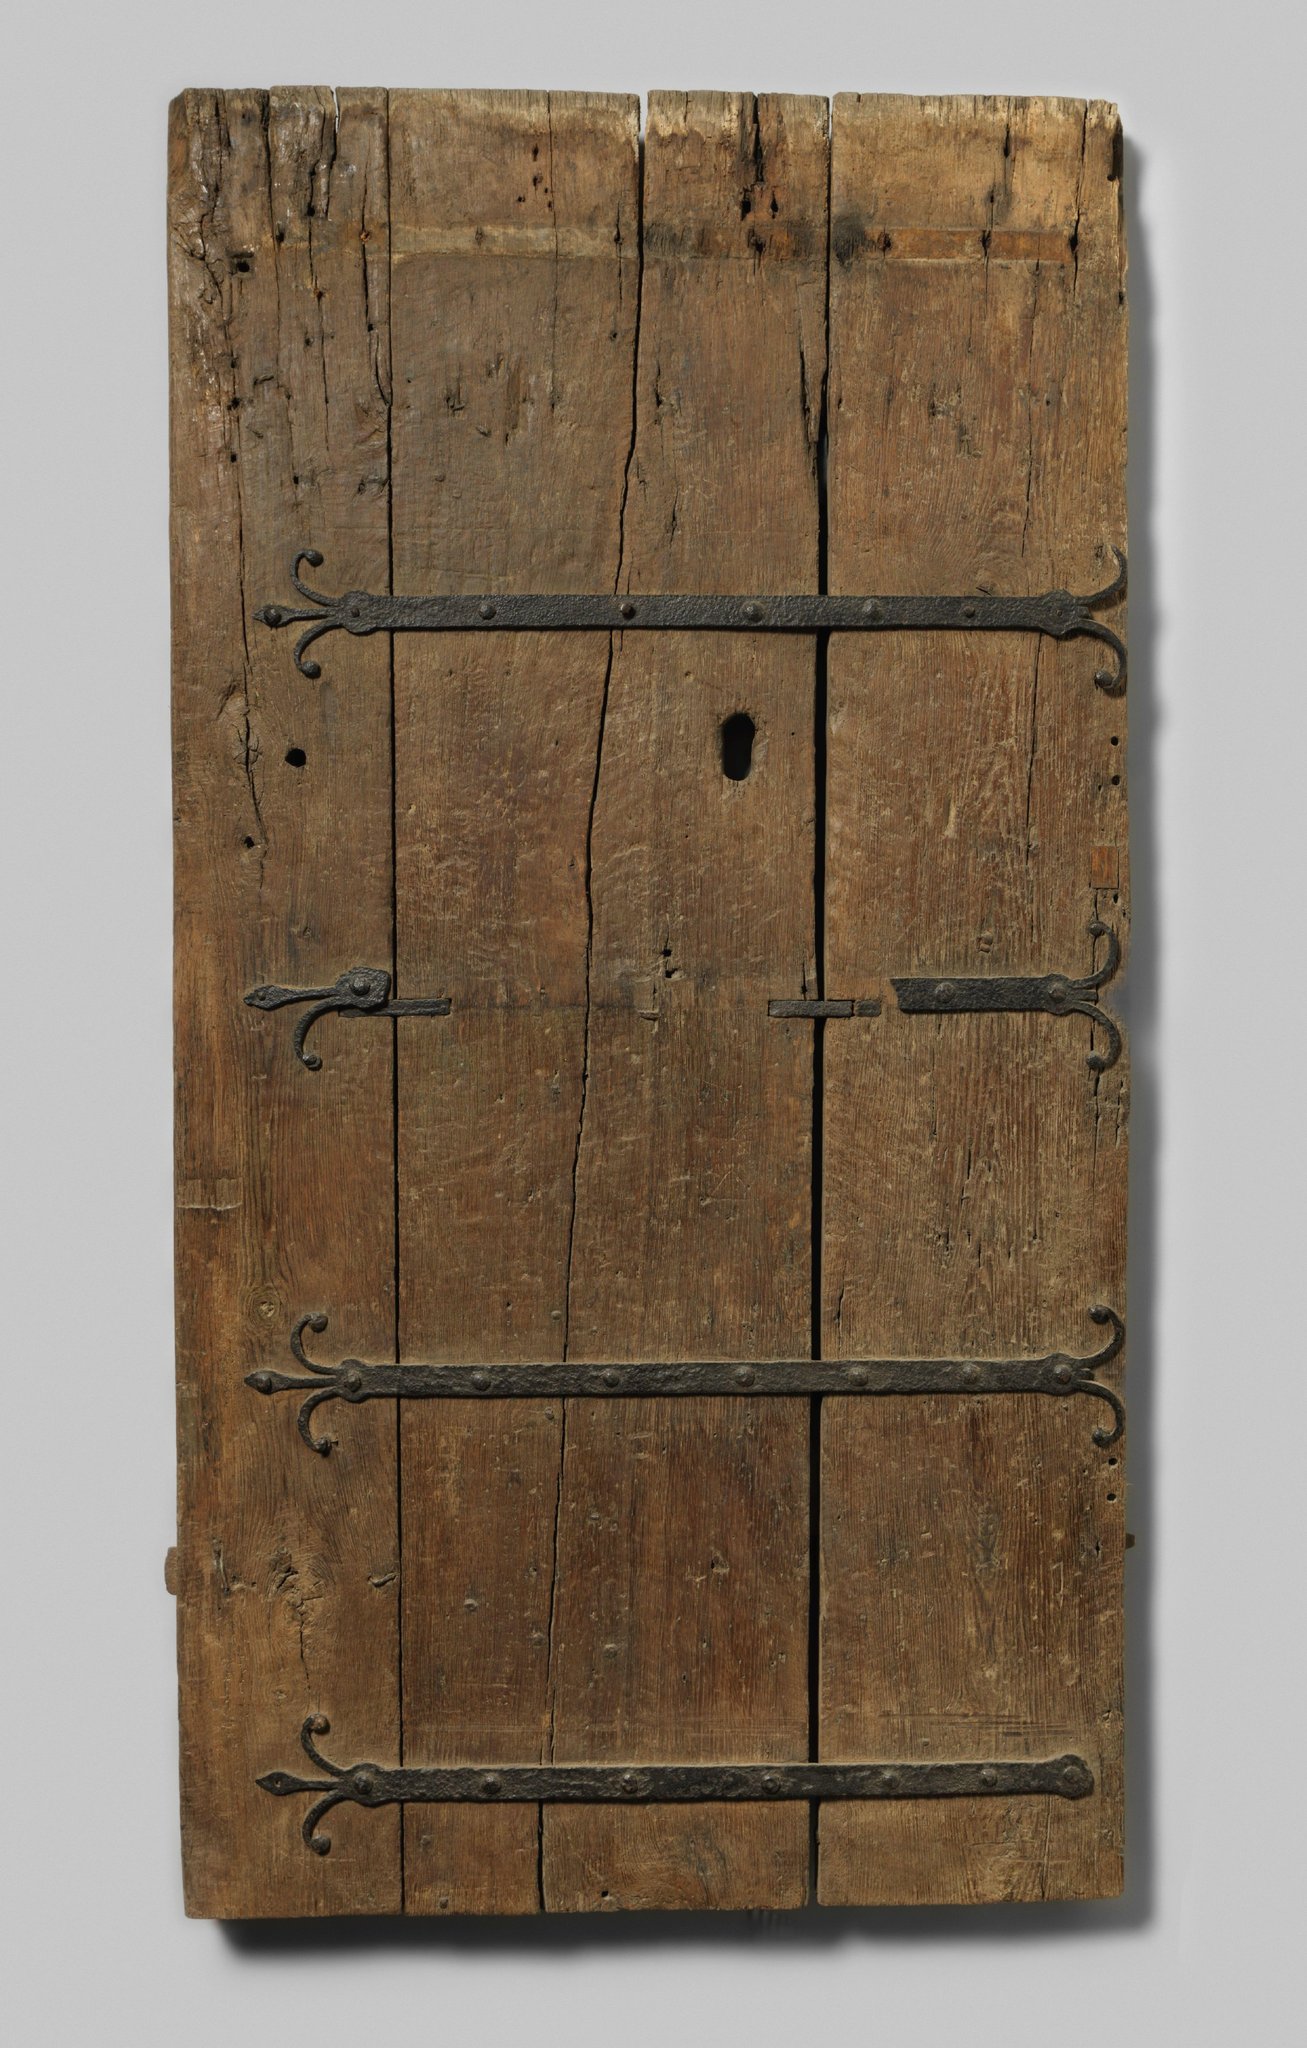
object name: architectural element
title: Fragment van een deur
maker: Anonymous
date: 1400-1500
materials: iron, wood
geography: northern netherlands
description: Fragment van een deur, bestaande uit drie brede planken, die door ijzeren krammen met elkaar zijn verbonden. De deur is beslagen met ijzeren hengsels, soms eindigend in een gestileerde lelie. Vermoedelijk gaat het om de fragmenten van deuren uit de St. Servaaskerk te Maastricht. Zie tevens: BK-NM-G-9259-a/b.